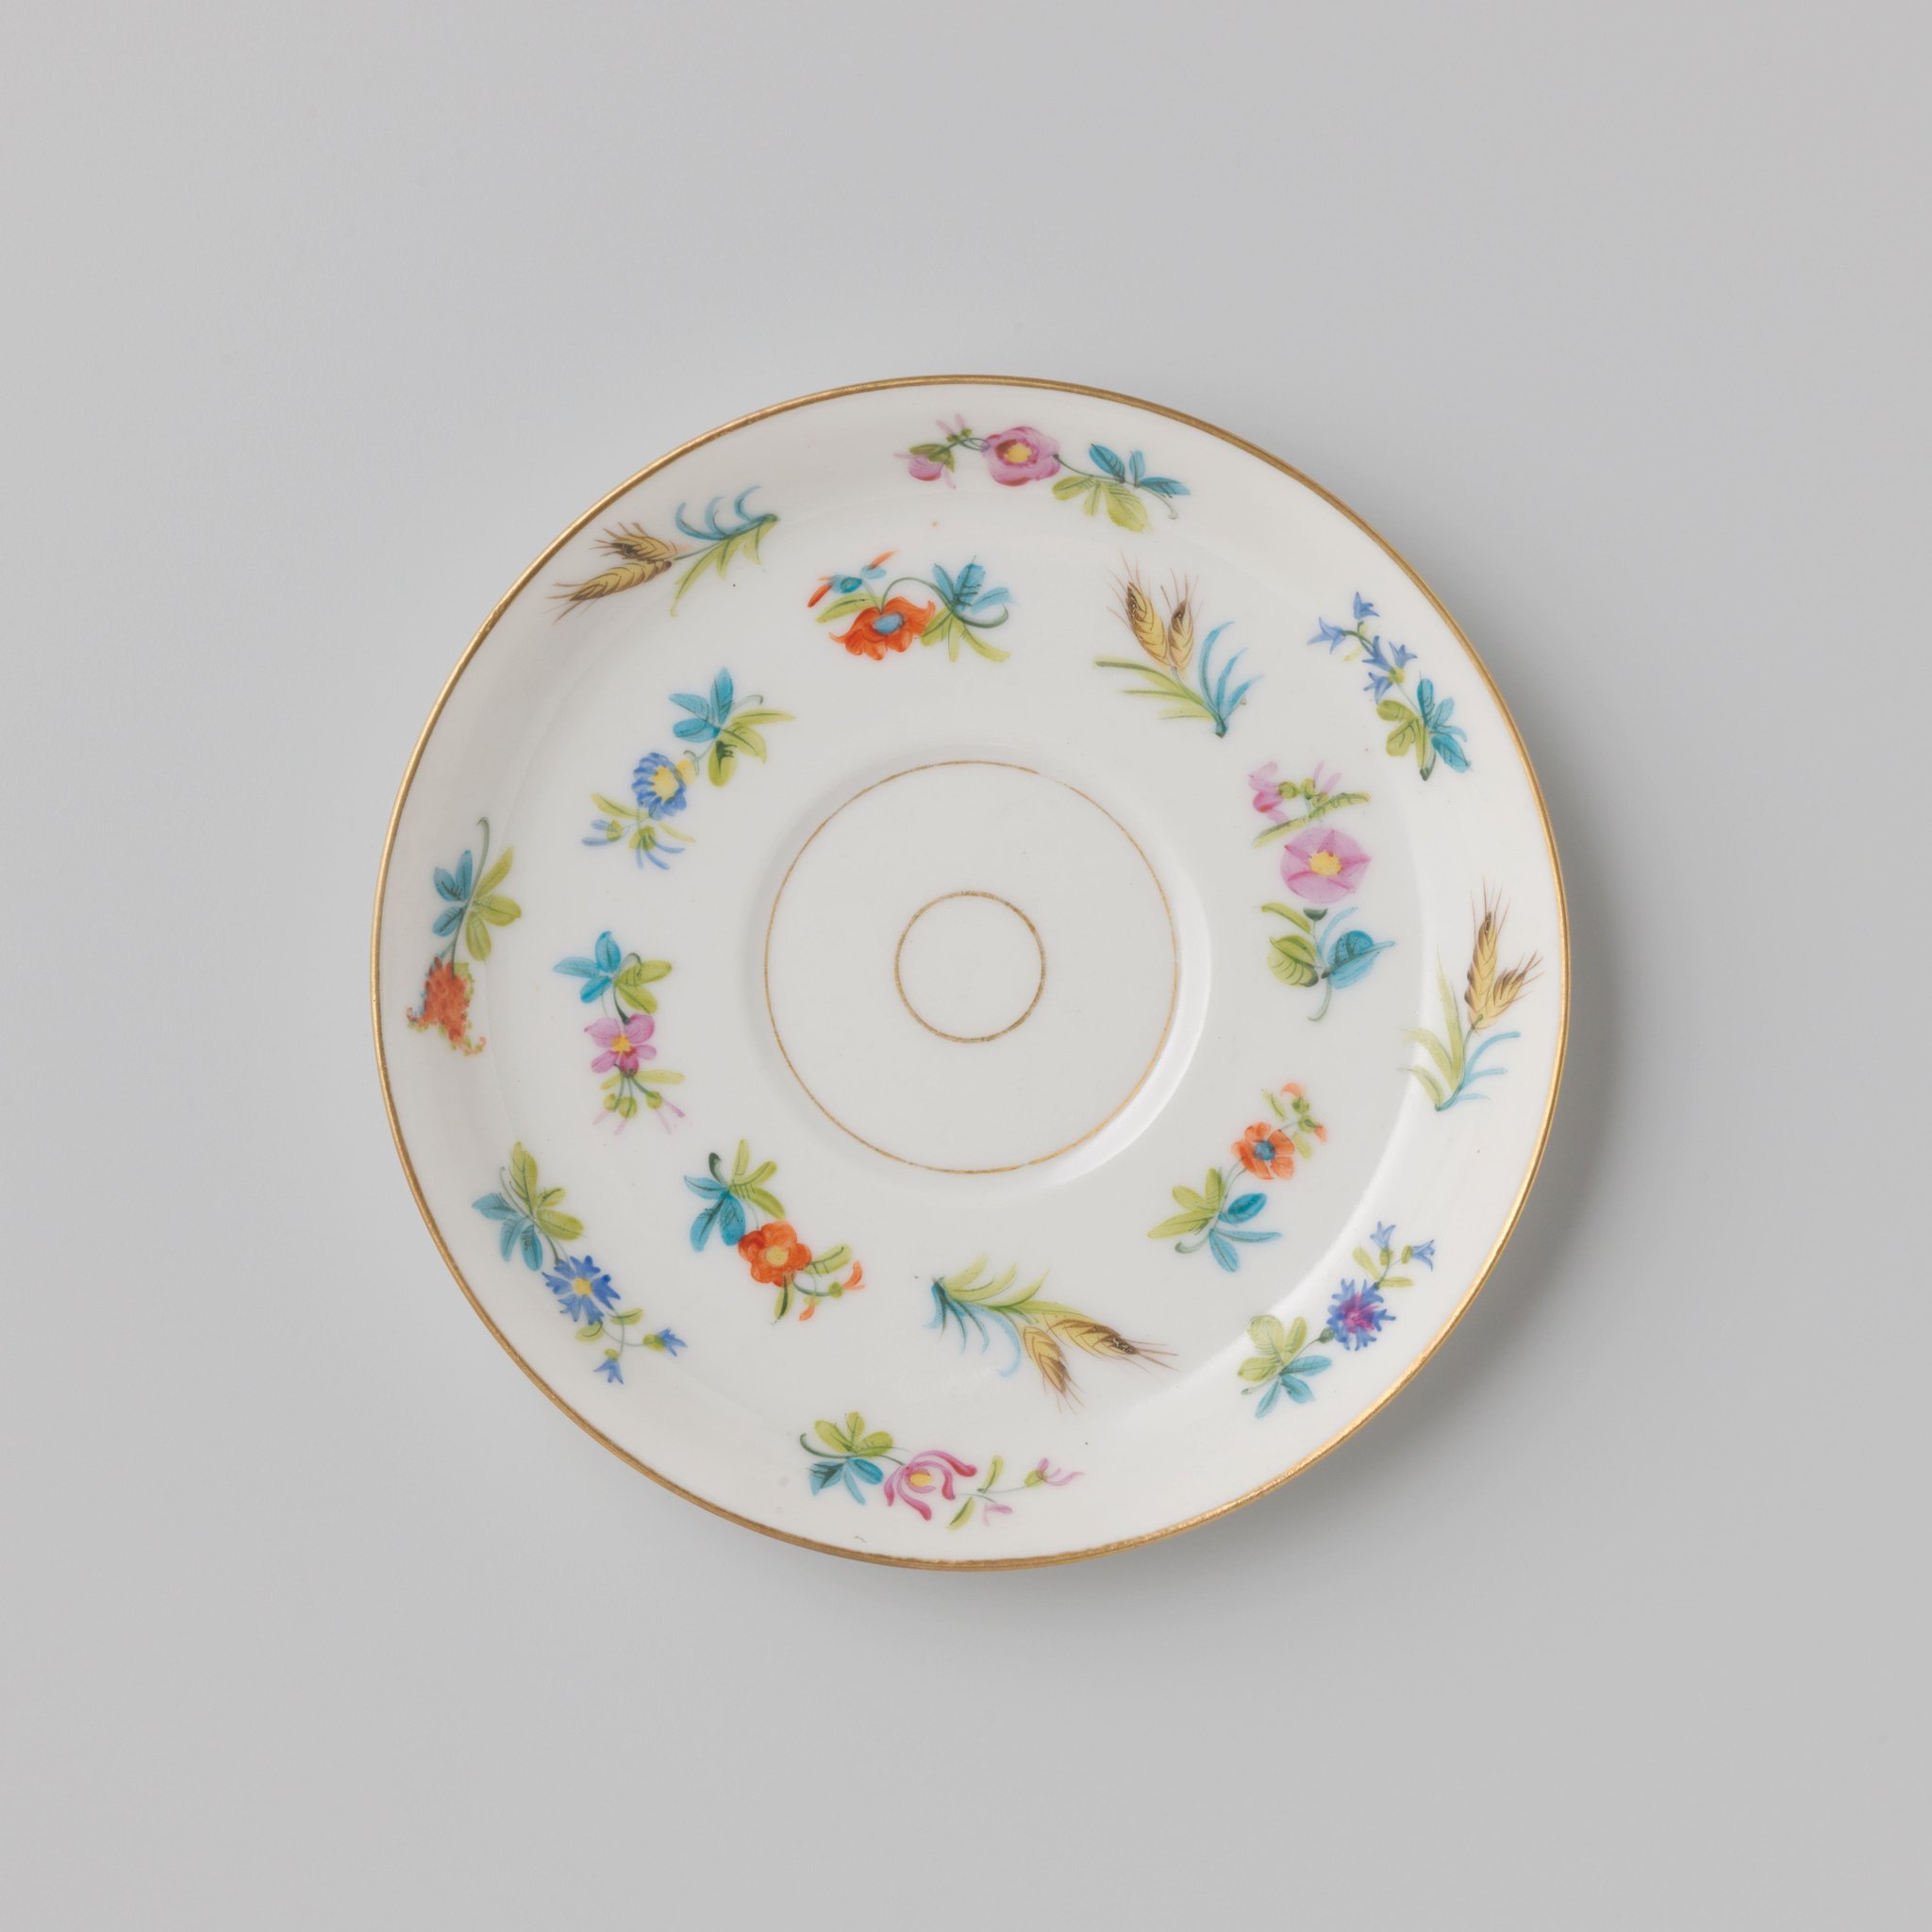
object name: platter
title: Saucer with flower sprays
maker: Anonymous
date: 1860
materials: glaze, gold, paint, porcelain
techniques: firing, forming, gilding, turning, vitrification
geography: france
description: Schotel van porselein, beschilderd op het glazuur in blauw, rood, roze, groen, geel, bruin en goud. Op het plat een dubbele gouden cirkel met daaromheen en op de binnenwand een band van bloemtakken. Gouden rand. Drie proenen op de onderzijde.